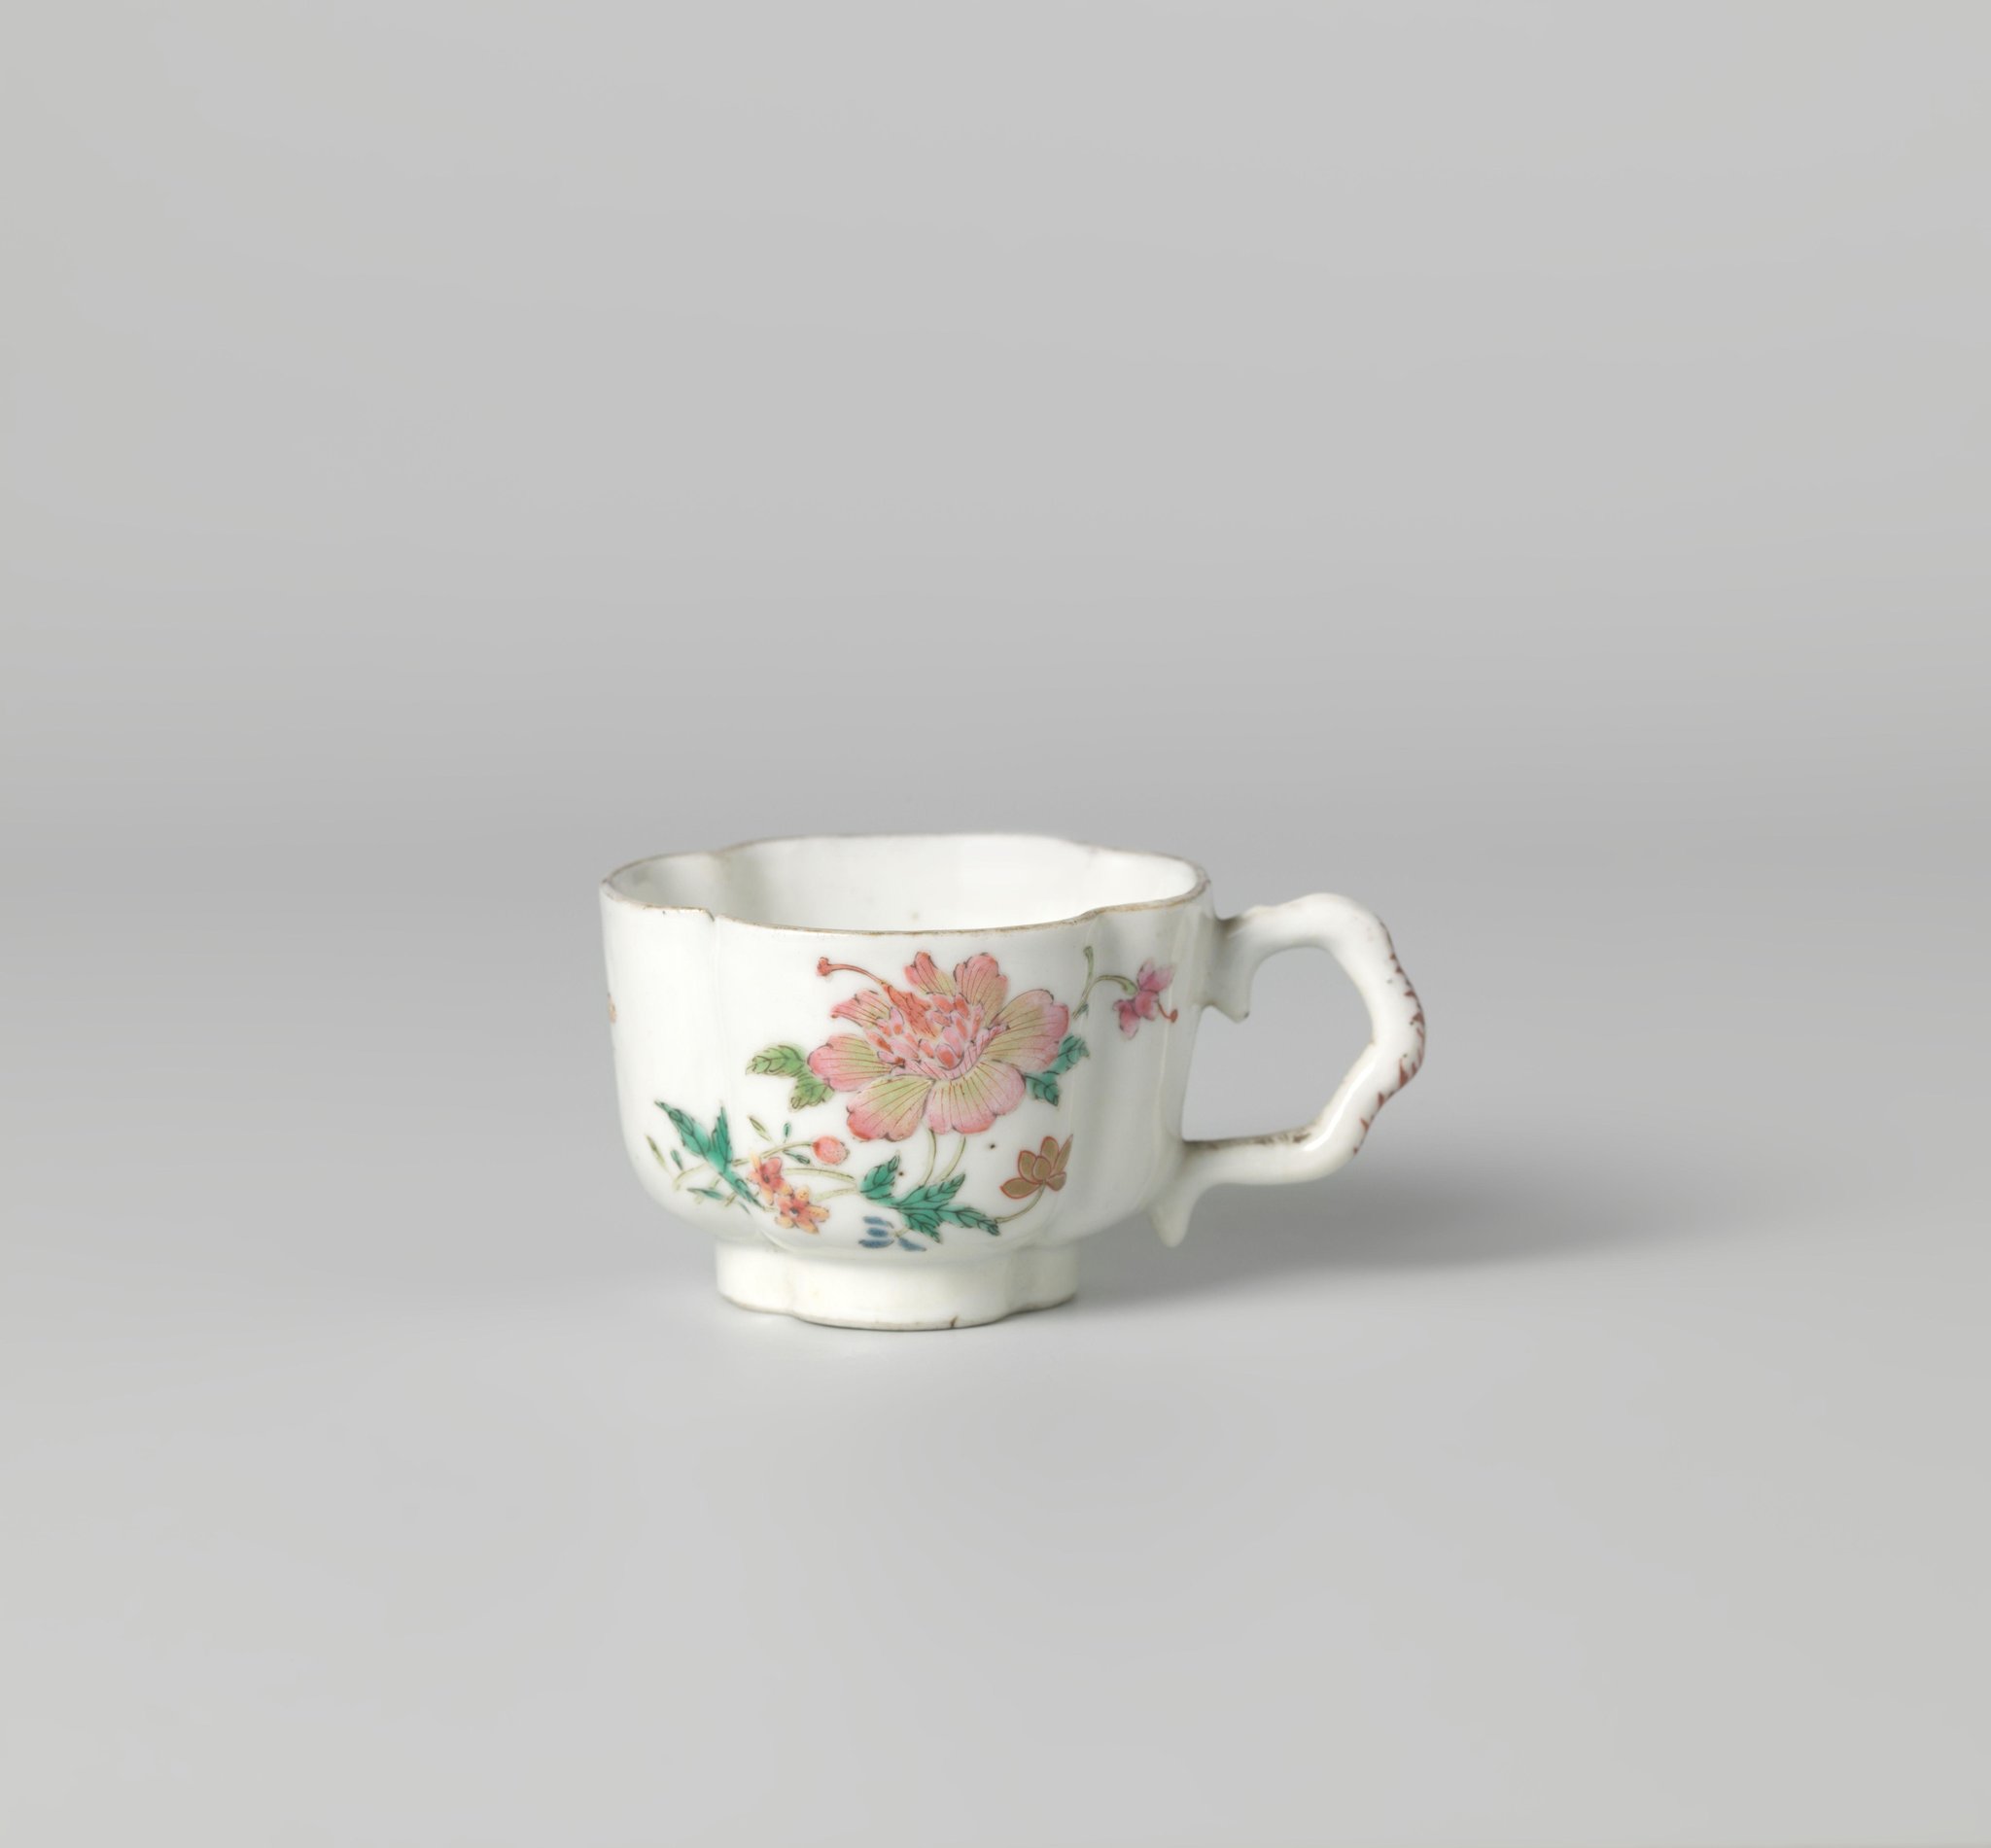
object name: kop en schotel, kop en schotel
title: Four-lobed cup with handle with flower sprays and butterflies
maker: Anonymous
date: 1725-1749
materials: glaze, gold, paint, porcelain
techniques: firing, forming, gilding, turning, vitrification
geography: china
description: Viermaal gelobde oorkop van porselein met c-vormig oor, beschilderd op het glazuur in blauw, rood, roze, groen, geel, zwart en goud. Losse bloemtakken en twee vlinders afgebeeld. Op het oor een tak. Famille rose.